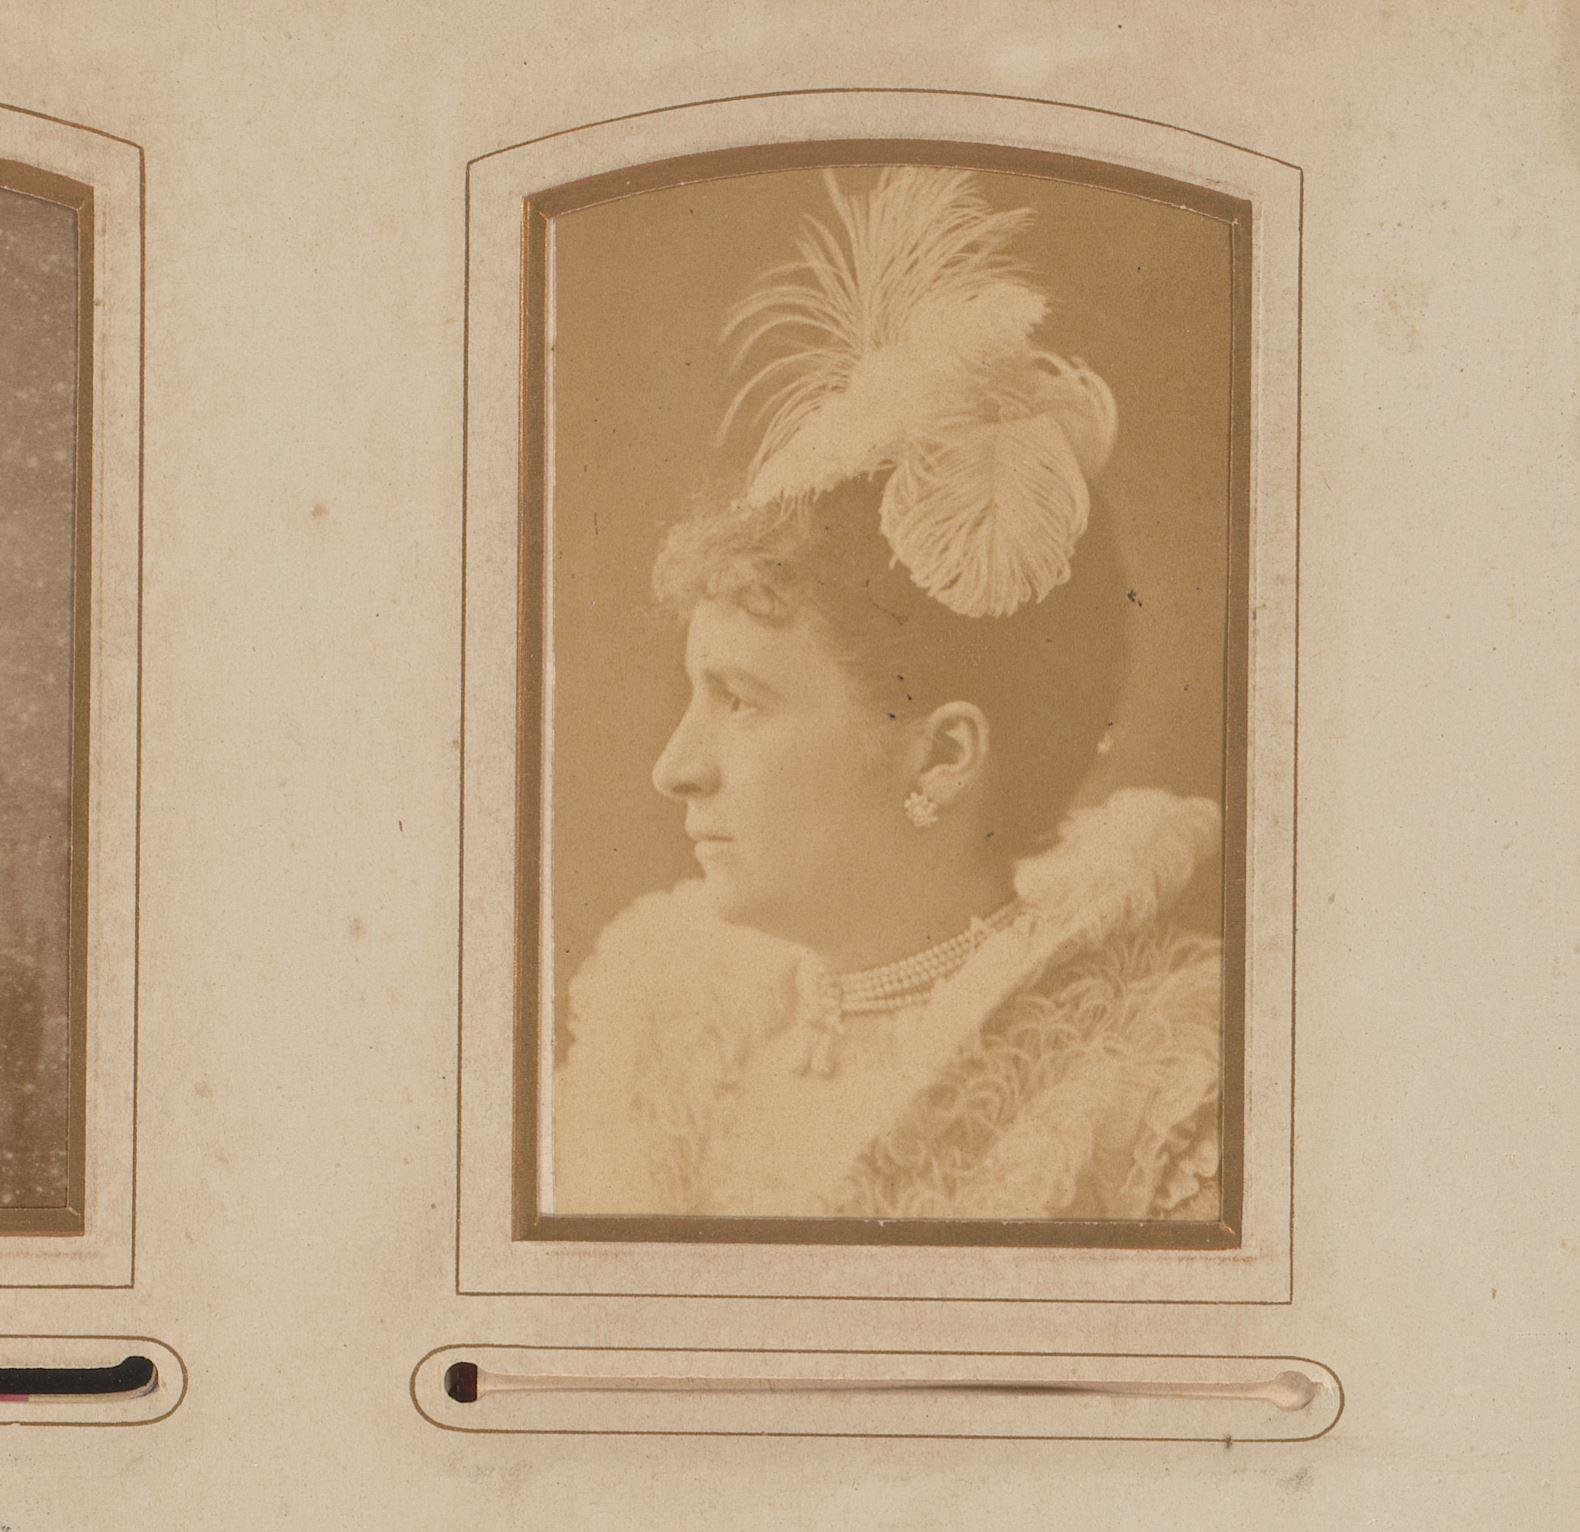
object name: photograph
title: Portret van een vrouw met veren in haar haren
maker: Anonymous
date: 1850-1900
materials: cardboard, photographic support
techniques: albumen print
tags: historical persons - bb - woman, hairdress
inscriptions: inscription: ‘Elmenreich./ 1293.’